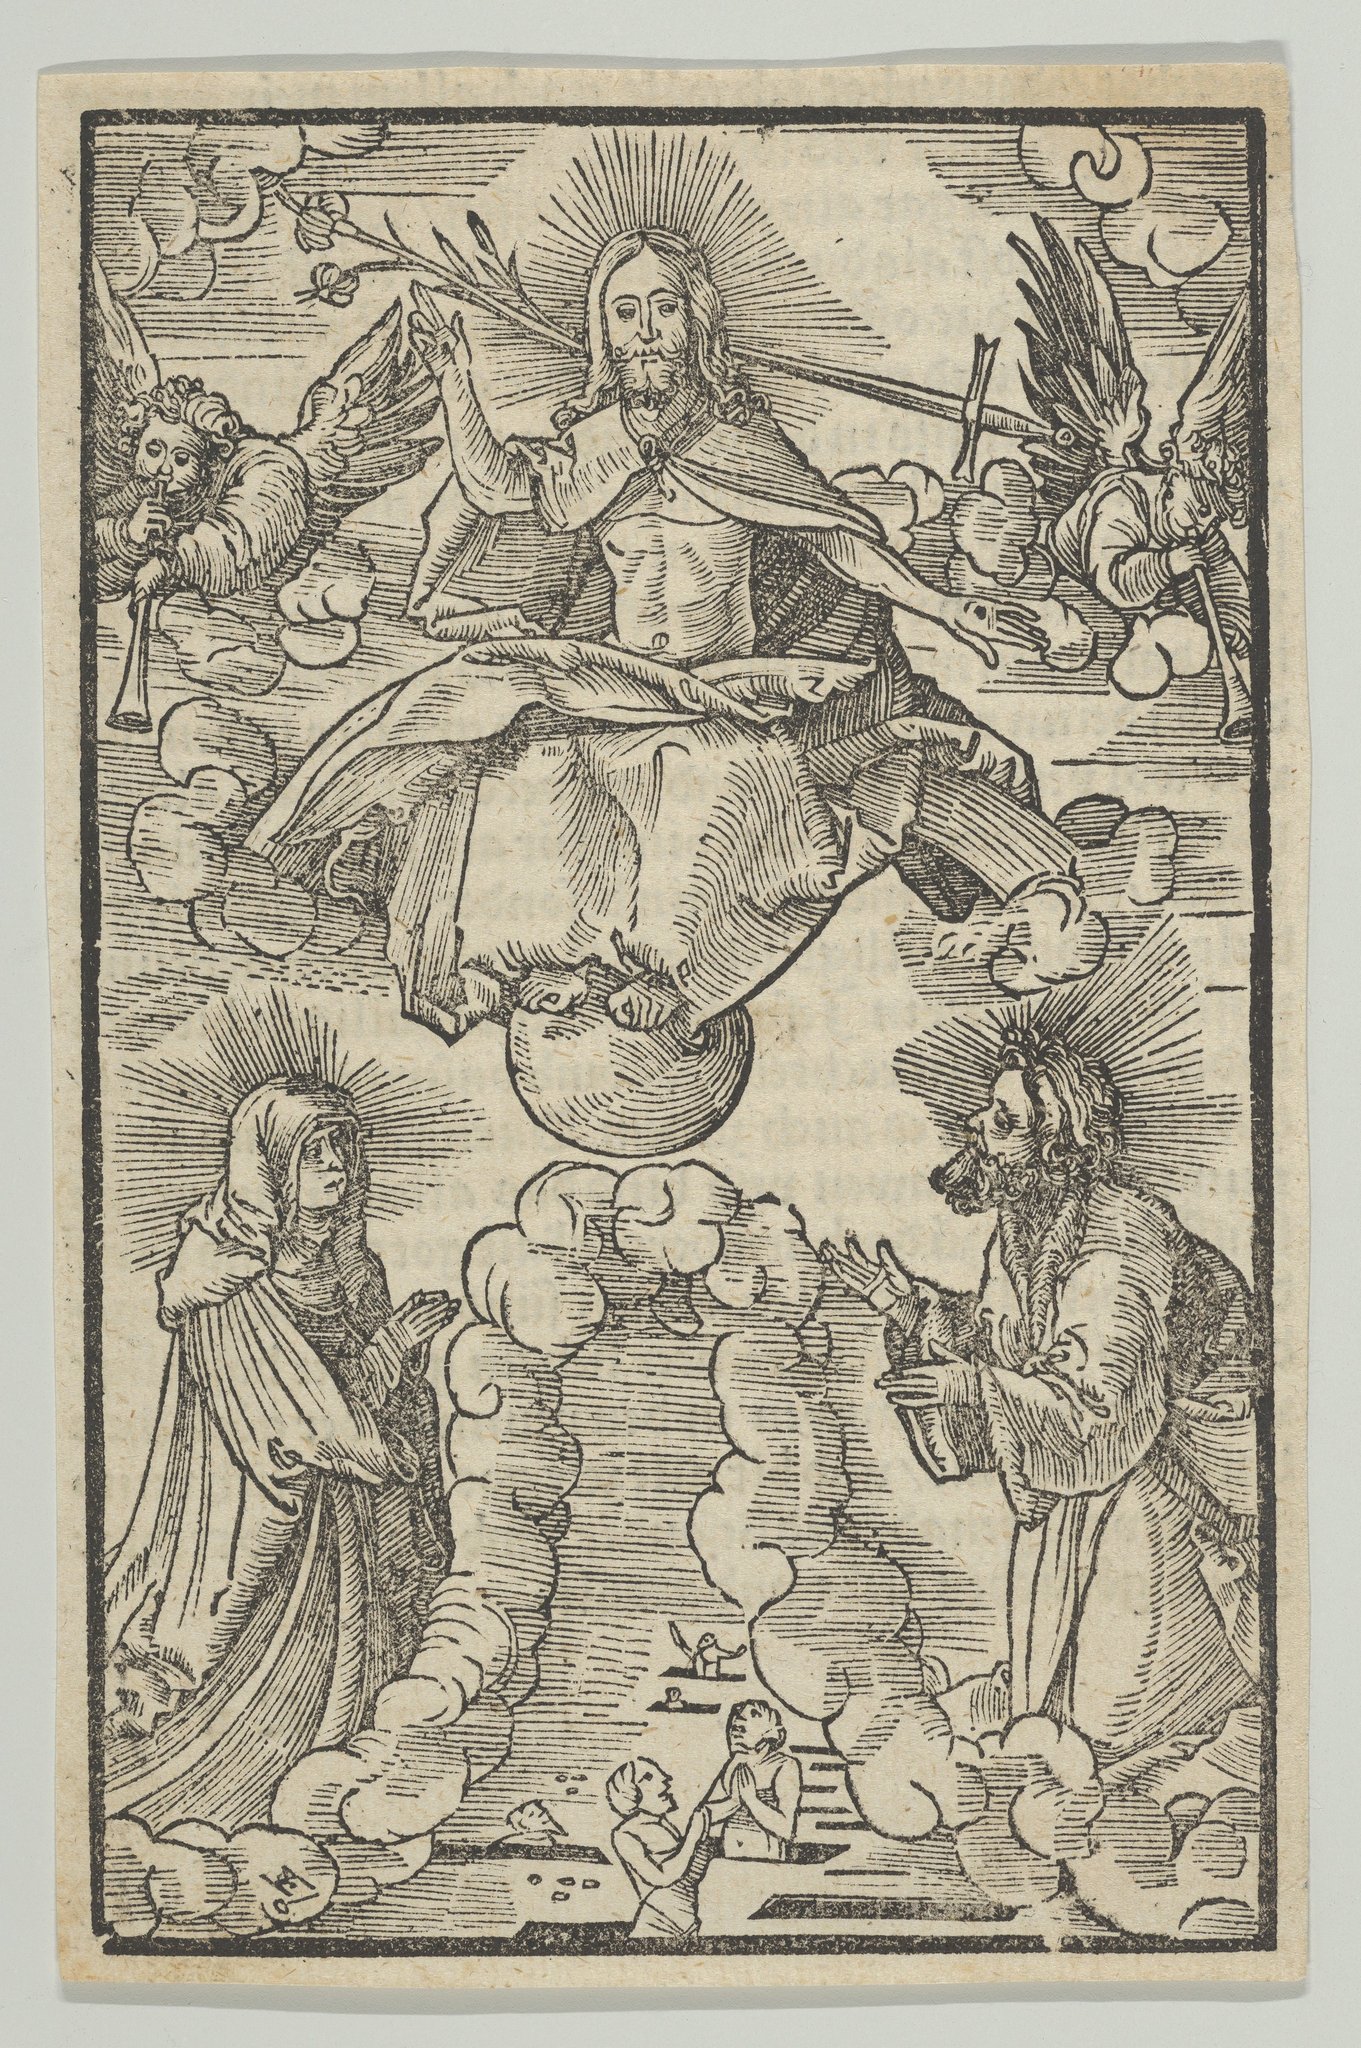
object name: print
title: The Last Judgment, from Hymmelwagen auff dem, wer wol lebt...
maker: hans schäufelein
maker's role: artist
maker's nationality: german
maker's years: 1480-1540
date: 1517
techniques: woodcut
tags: men,women,angels,christ,last judgement